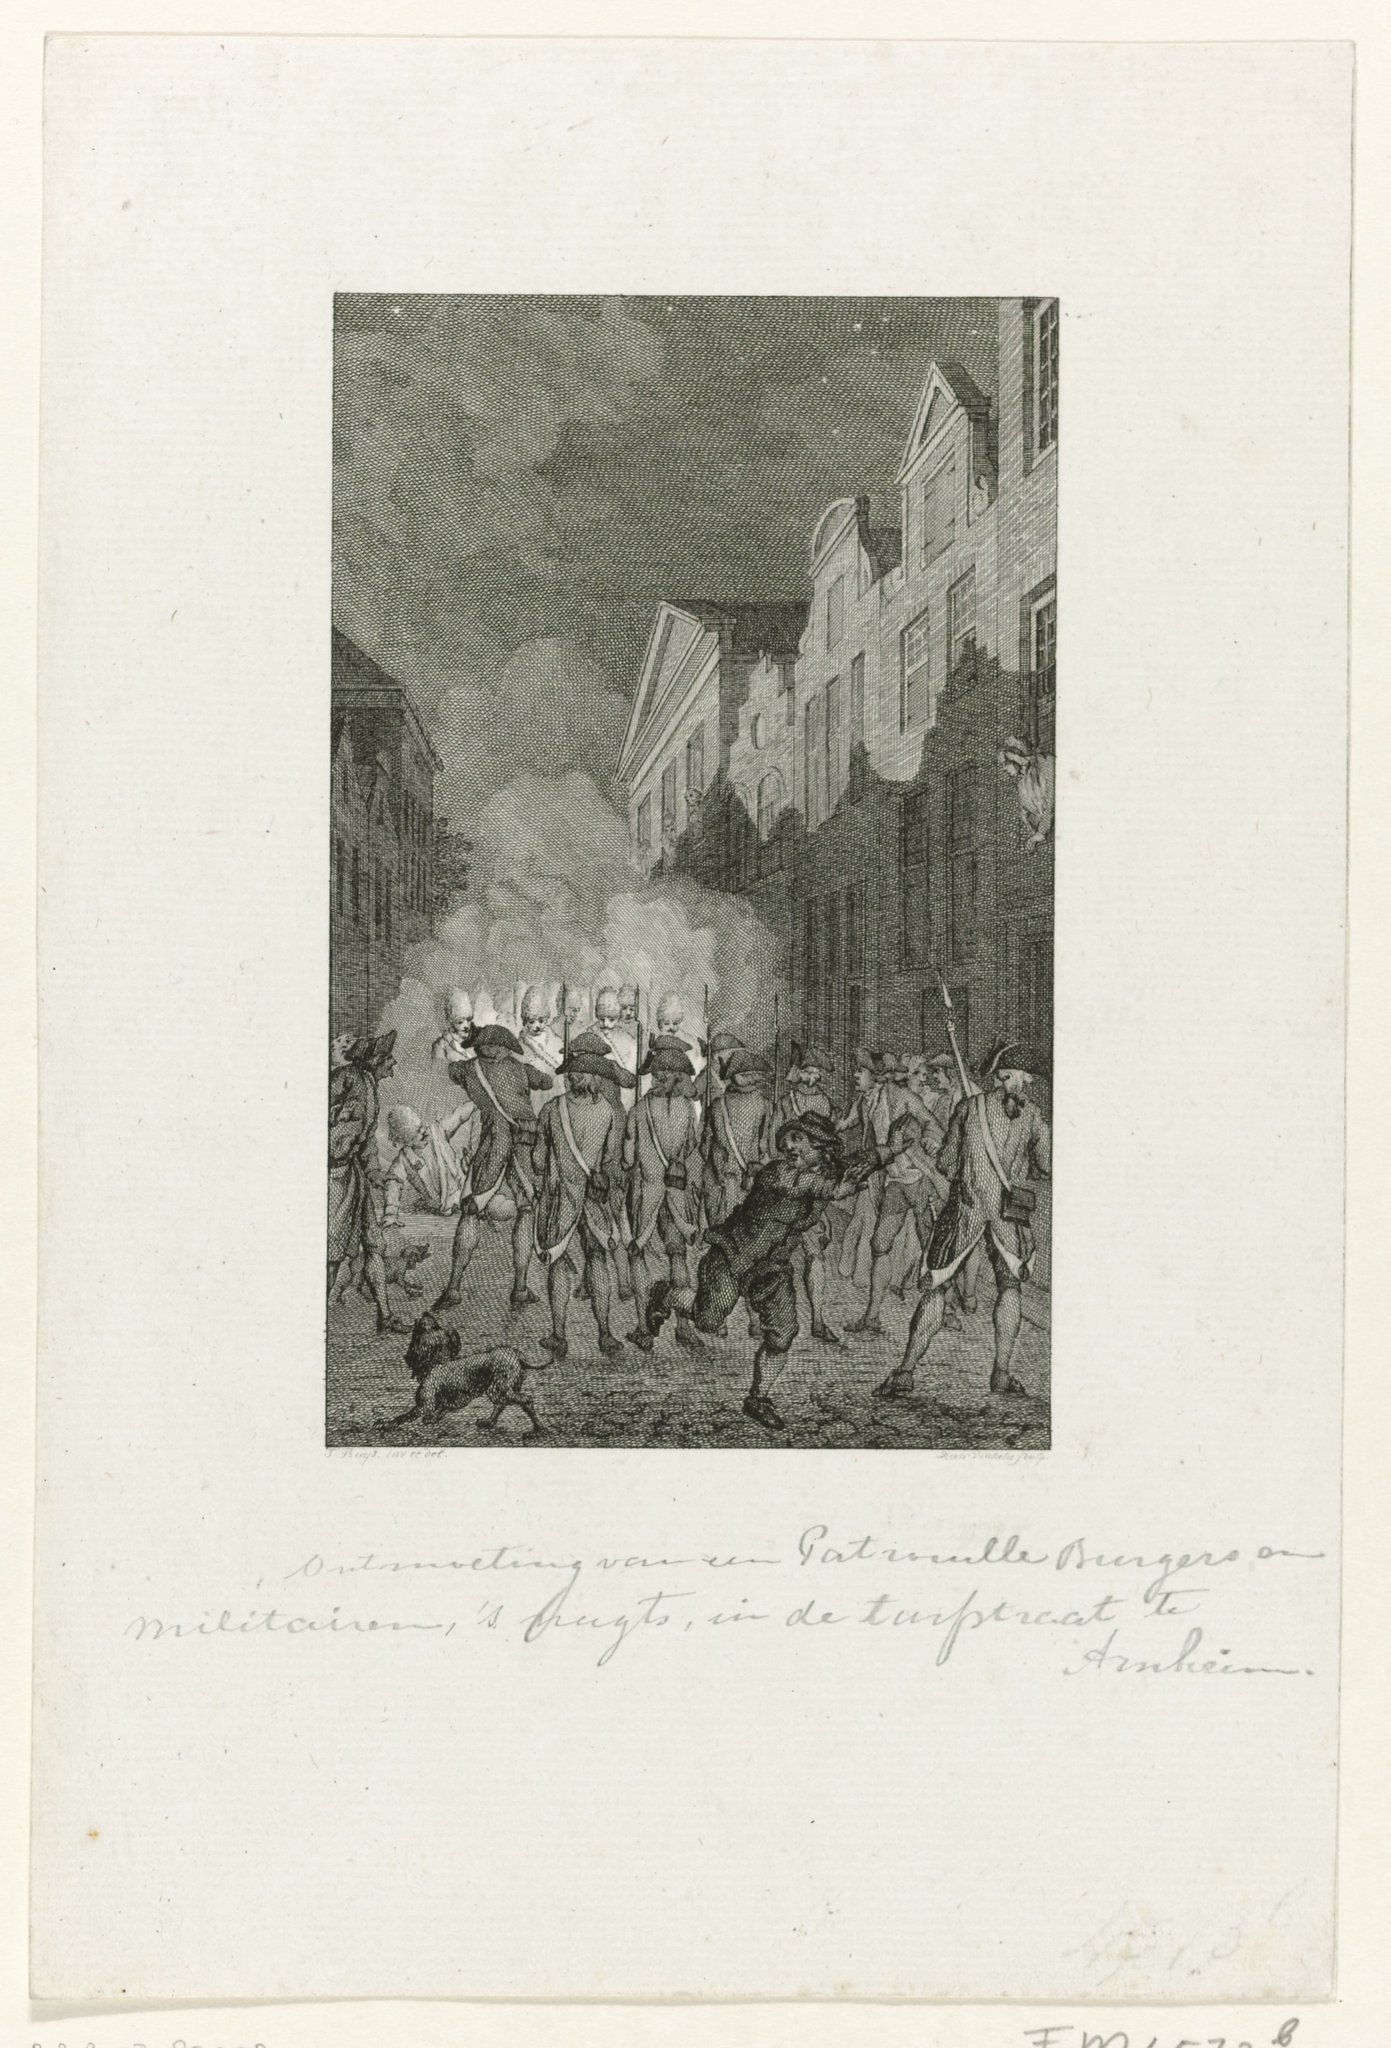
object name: history print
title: Confrontatie tussen burgerpatrouille en militaire patrouille te Arnhem, 1784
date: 1788-1790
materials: paper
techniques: engraving, etching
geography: northern netherlands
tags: warfare; military affairs (+ citizen soldiery, civil guard, citizen militia), arnhem, patriots (1780-1795)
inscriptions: collector's mark: Lugt 2228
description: Gebruikt als illustratie in: P.A. Loosjes. Vaderlandsche historie, vervattende de geschiedenissen, der Vereenigde Nederlanden (...). Ten onmiddelyken vervolge van Wagenaar's Vaderlandsche historie. Amsterdam: Johannes Allart, dl. 3, 1790.